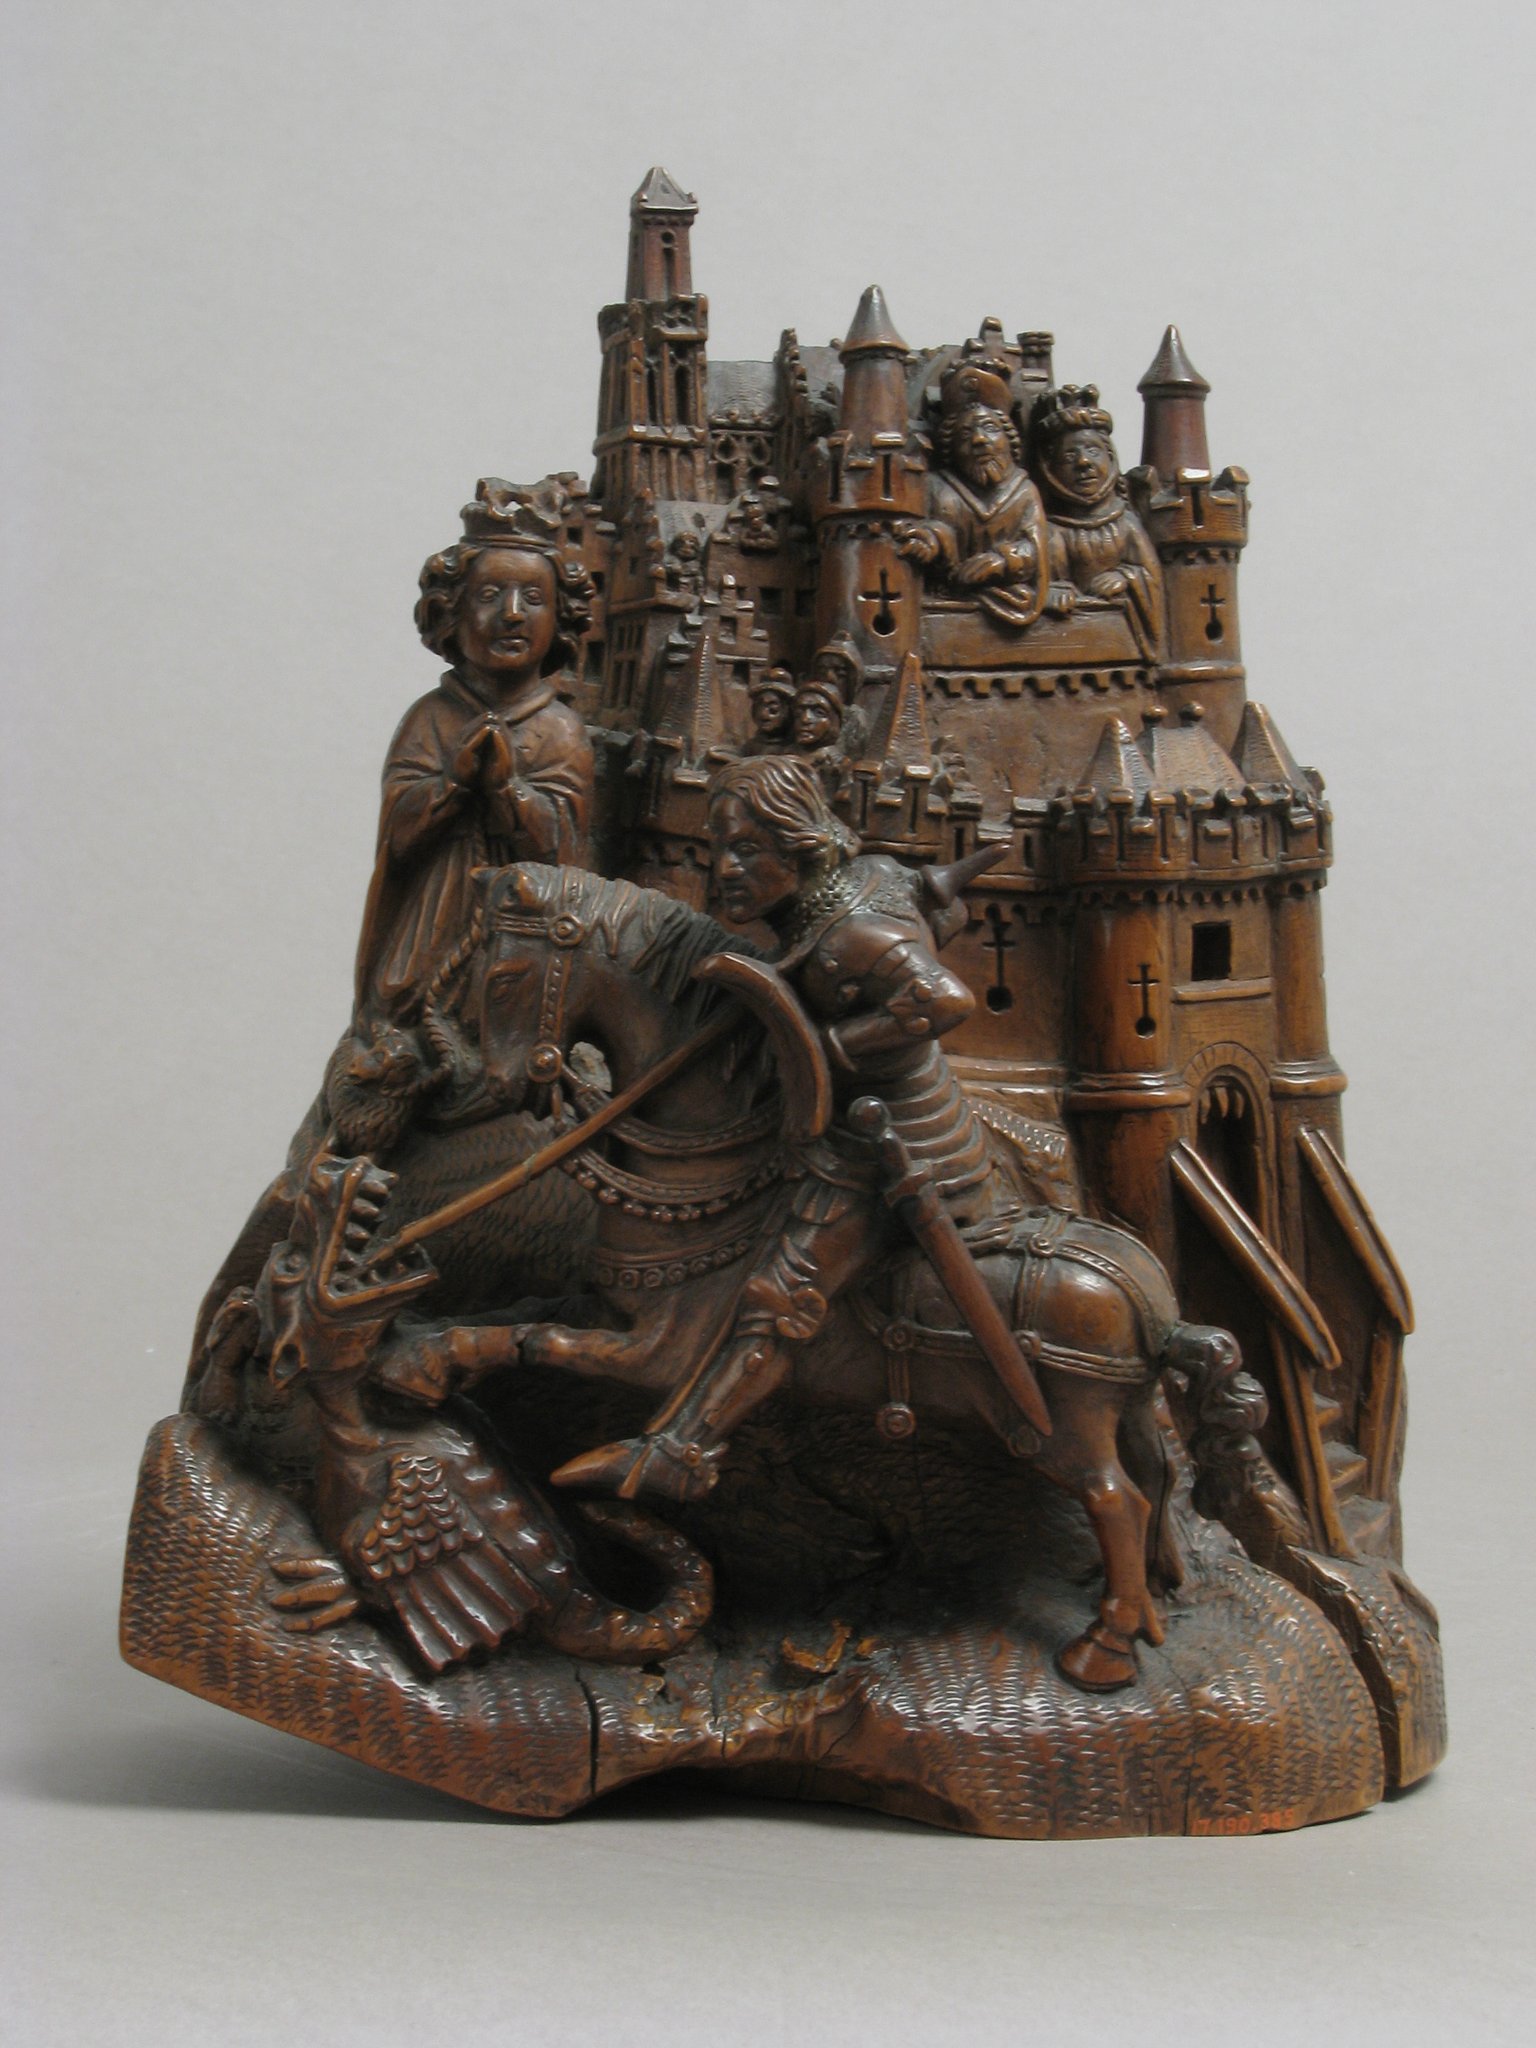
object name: statuette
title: St. George and the Dragon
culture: german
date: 1401-1600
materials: wood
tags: churches,dragons,horses